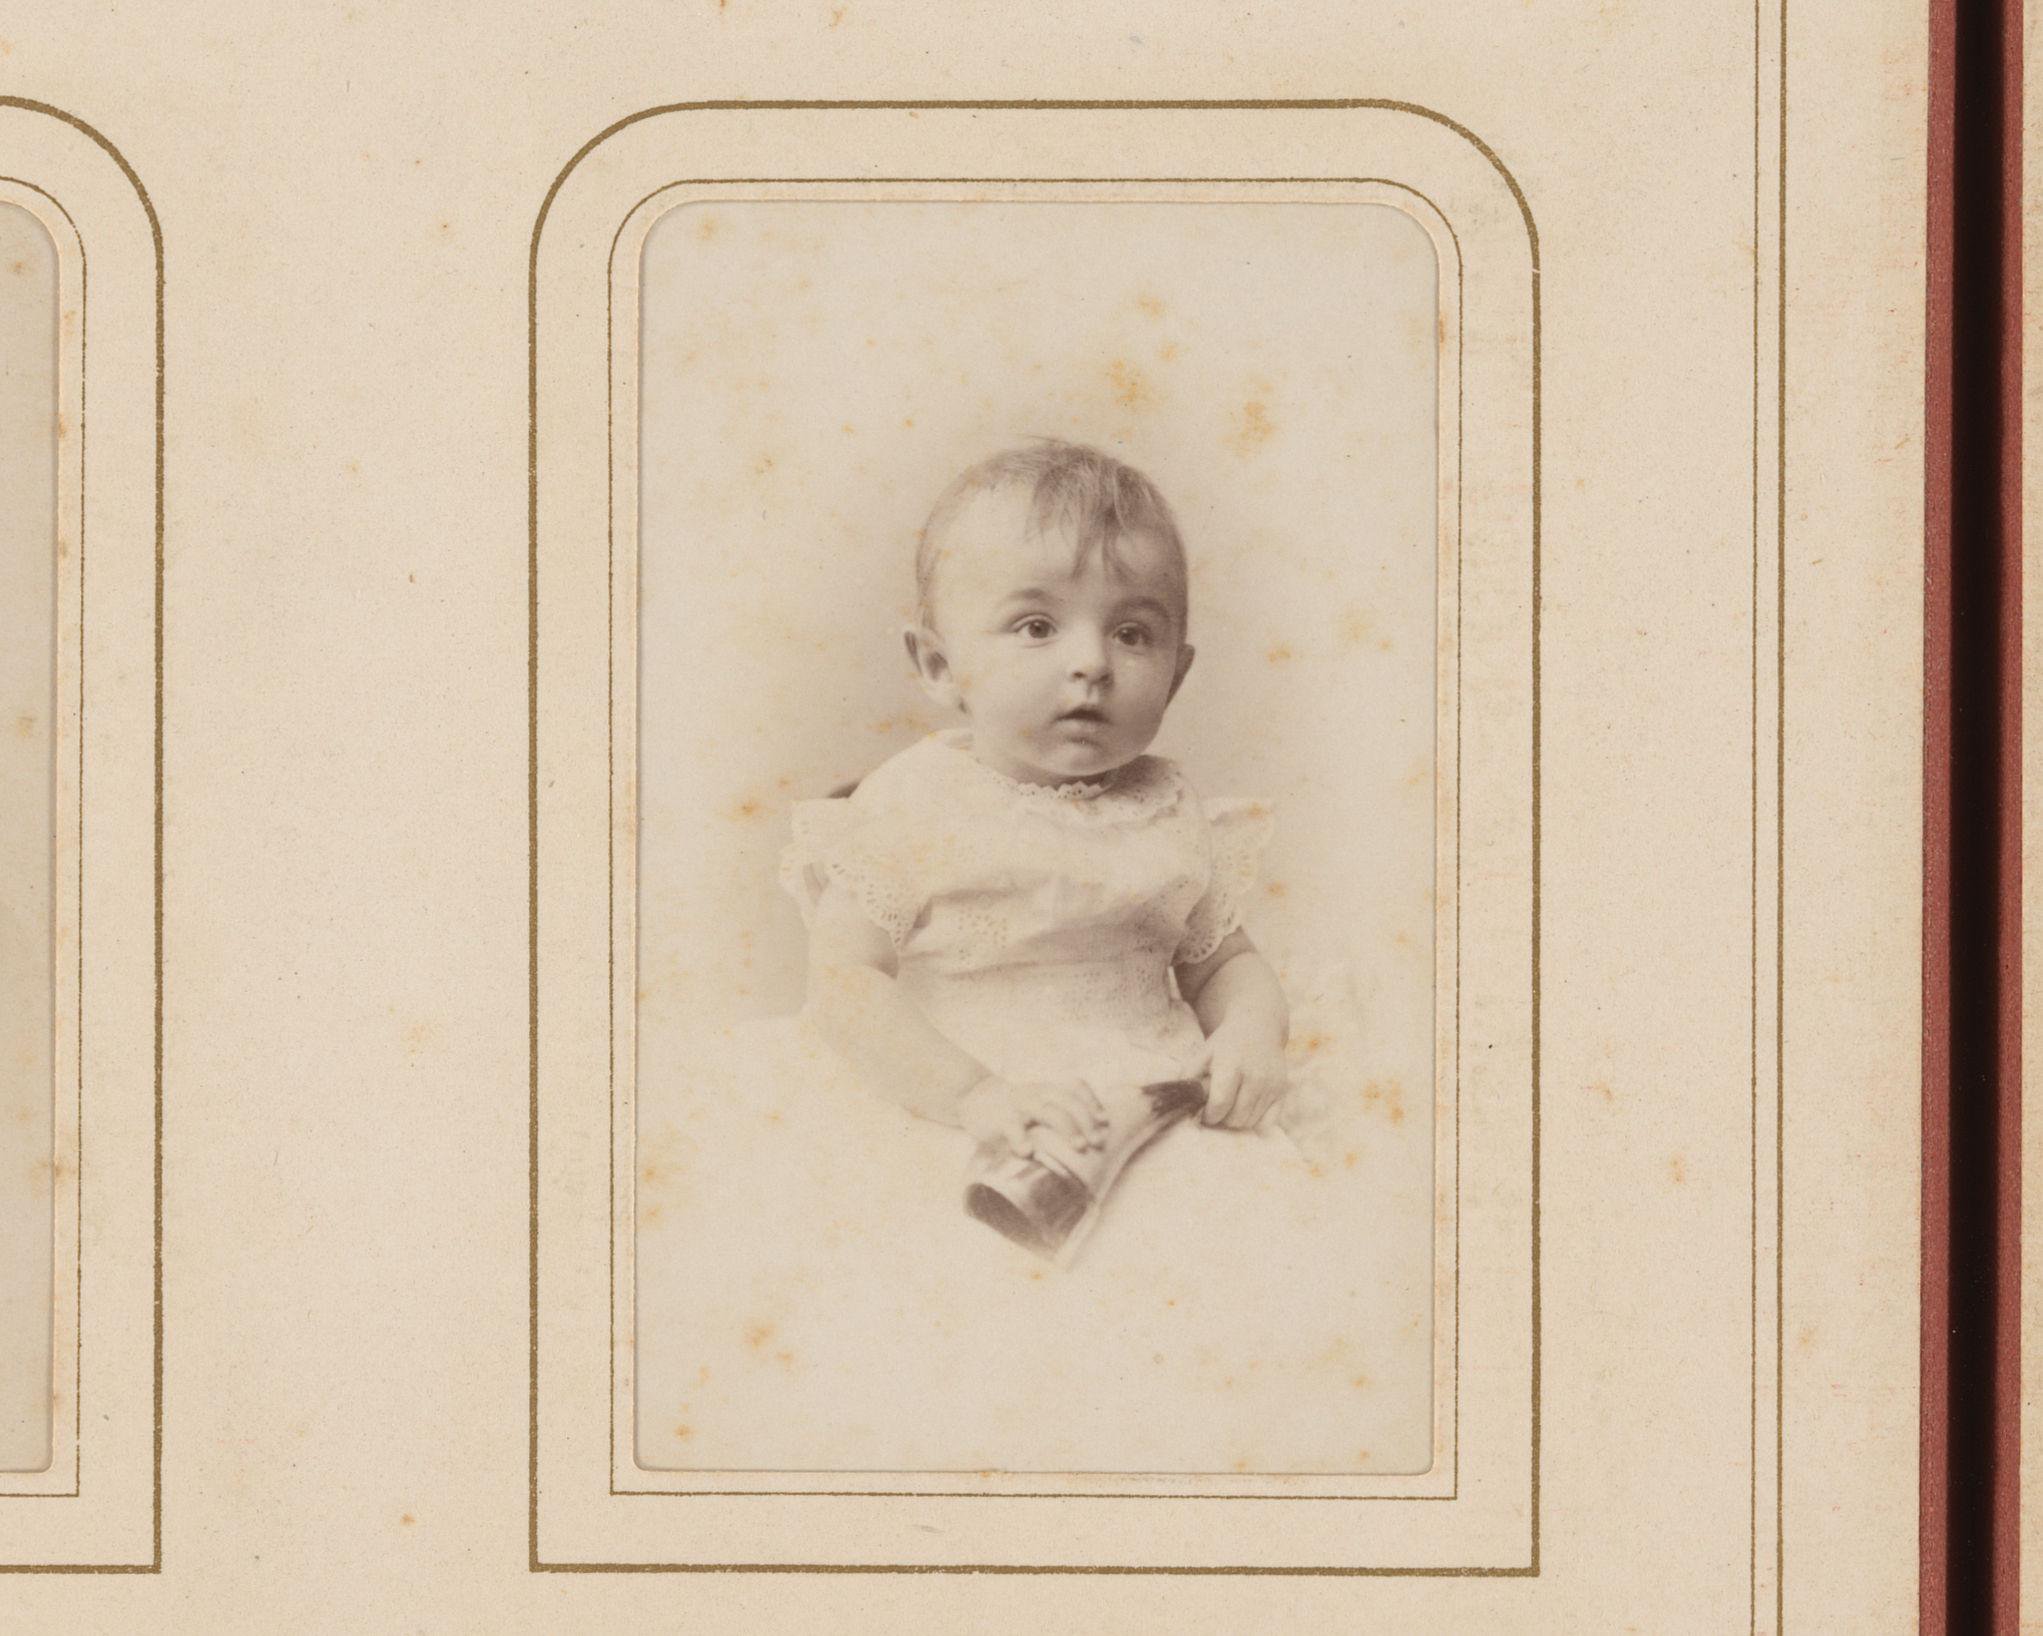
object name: carte de visite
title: Portret van een baby met een hoorn in de hand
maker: theodor prümm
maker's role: fotograaf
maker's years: 1841-1890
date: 1888-1900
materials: cardboard, photographic support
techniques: albumen print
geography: berlin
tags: historical persons, infant, baby ~ the ages of man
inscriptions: inscription: ‘Inhaber der Preismedaillen/ WIEN/ 1873./ BERLIN/ 1865./ HAMBURG/ 1868./ THEODOR PRÜMM/ BERLIN/ Unter den Linden 51./ 1888./ Platten werden aufbewahrt’